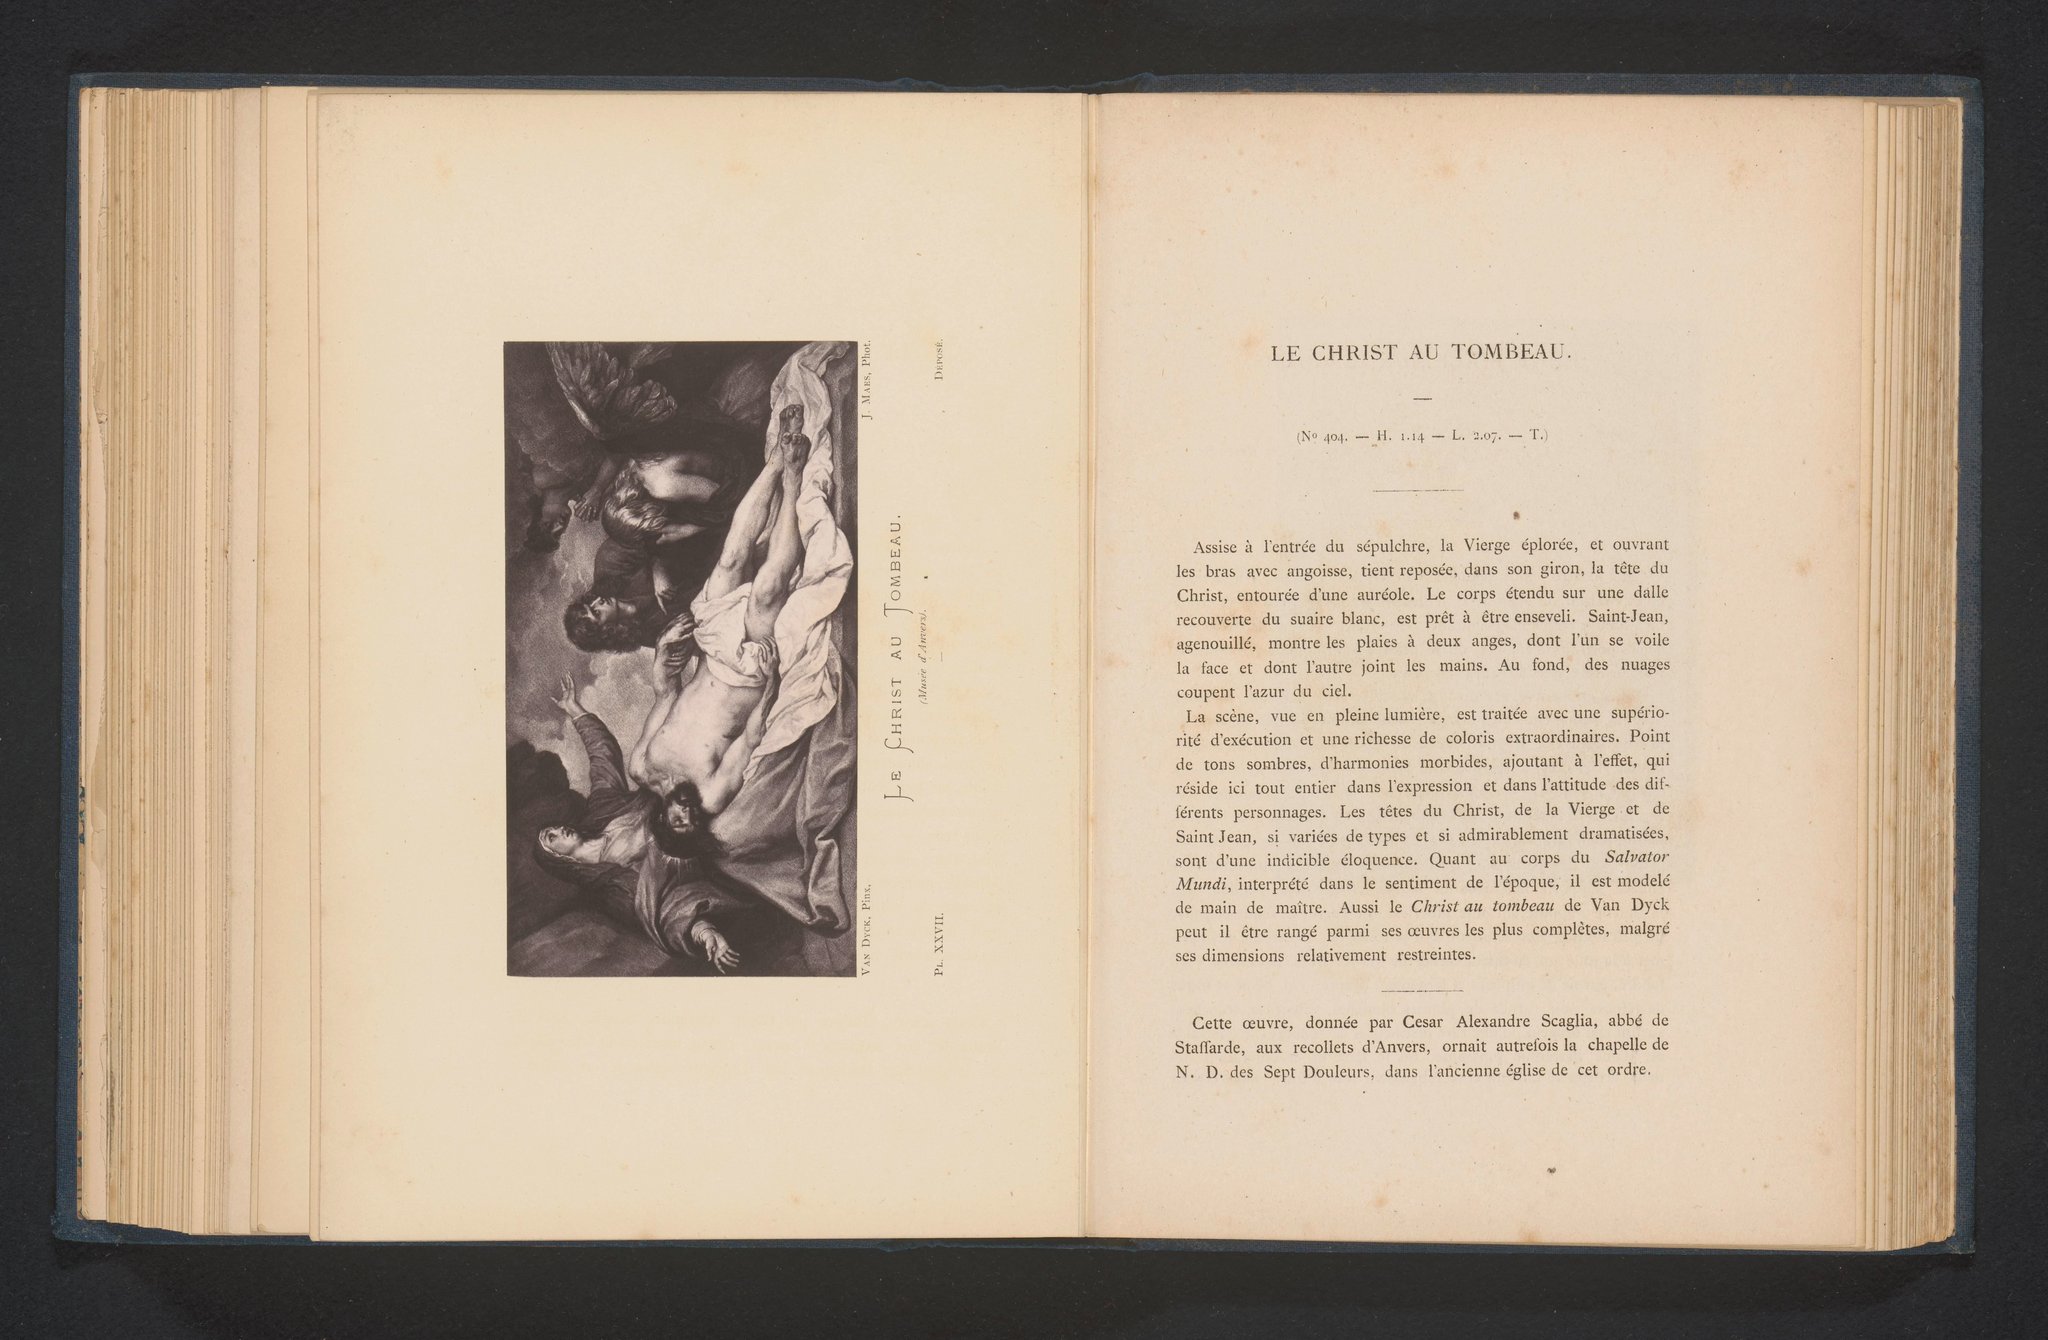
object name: page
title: Le Christ au Tombeau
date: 1872-1877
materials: paper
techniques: woodburytype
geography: antwerp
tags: christ's body on or in the grave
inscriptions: inscription: ‘(Musée d'Anvers)/ Pl. XXVII. Déposé.’